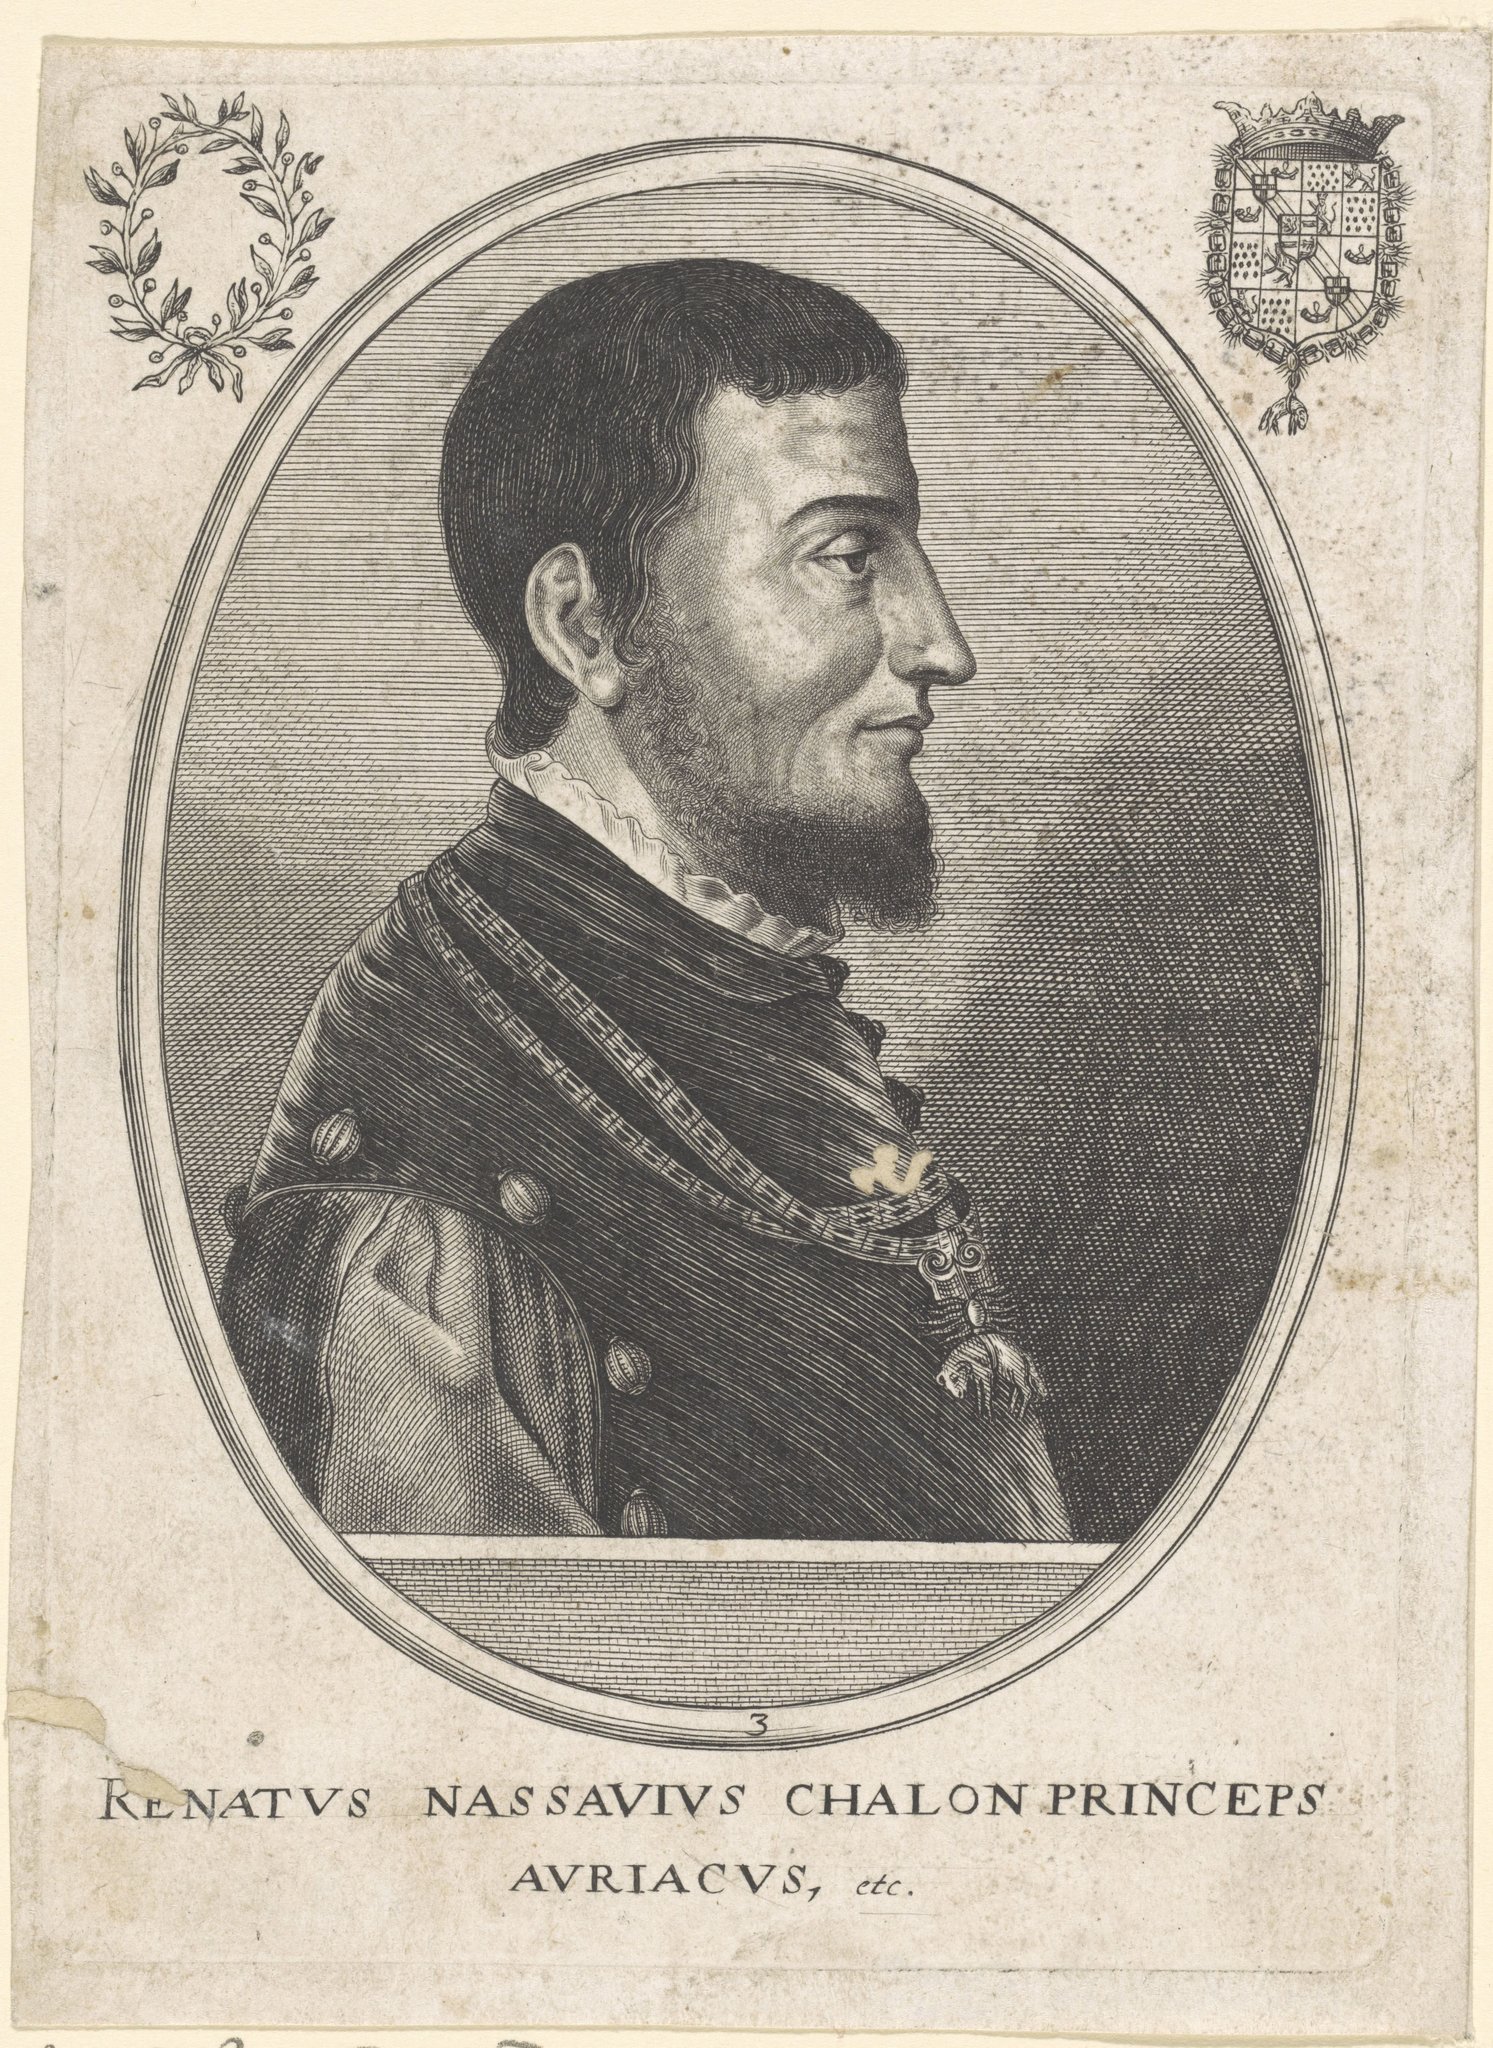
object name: print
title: Portret van René van Châlon, prins van Oranje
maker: balthazar moncornet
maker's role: print maker, publisher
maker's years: 1600-1668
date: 1610-1668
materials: paper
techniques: engraving, etching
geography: france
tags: knighthood order of the golden fleece - insignia of a knighthood order, e.g.: badge, chain (with name of order)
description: De hier vermelde titel verwijst naar de hoogst verkregen titel van de geportretteerde, niet per se naar de titel die de geportretteerde op deze voorstelling draagt.